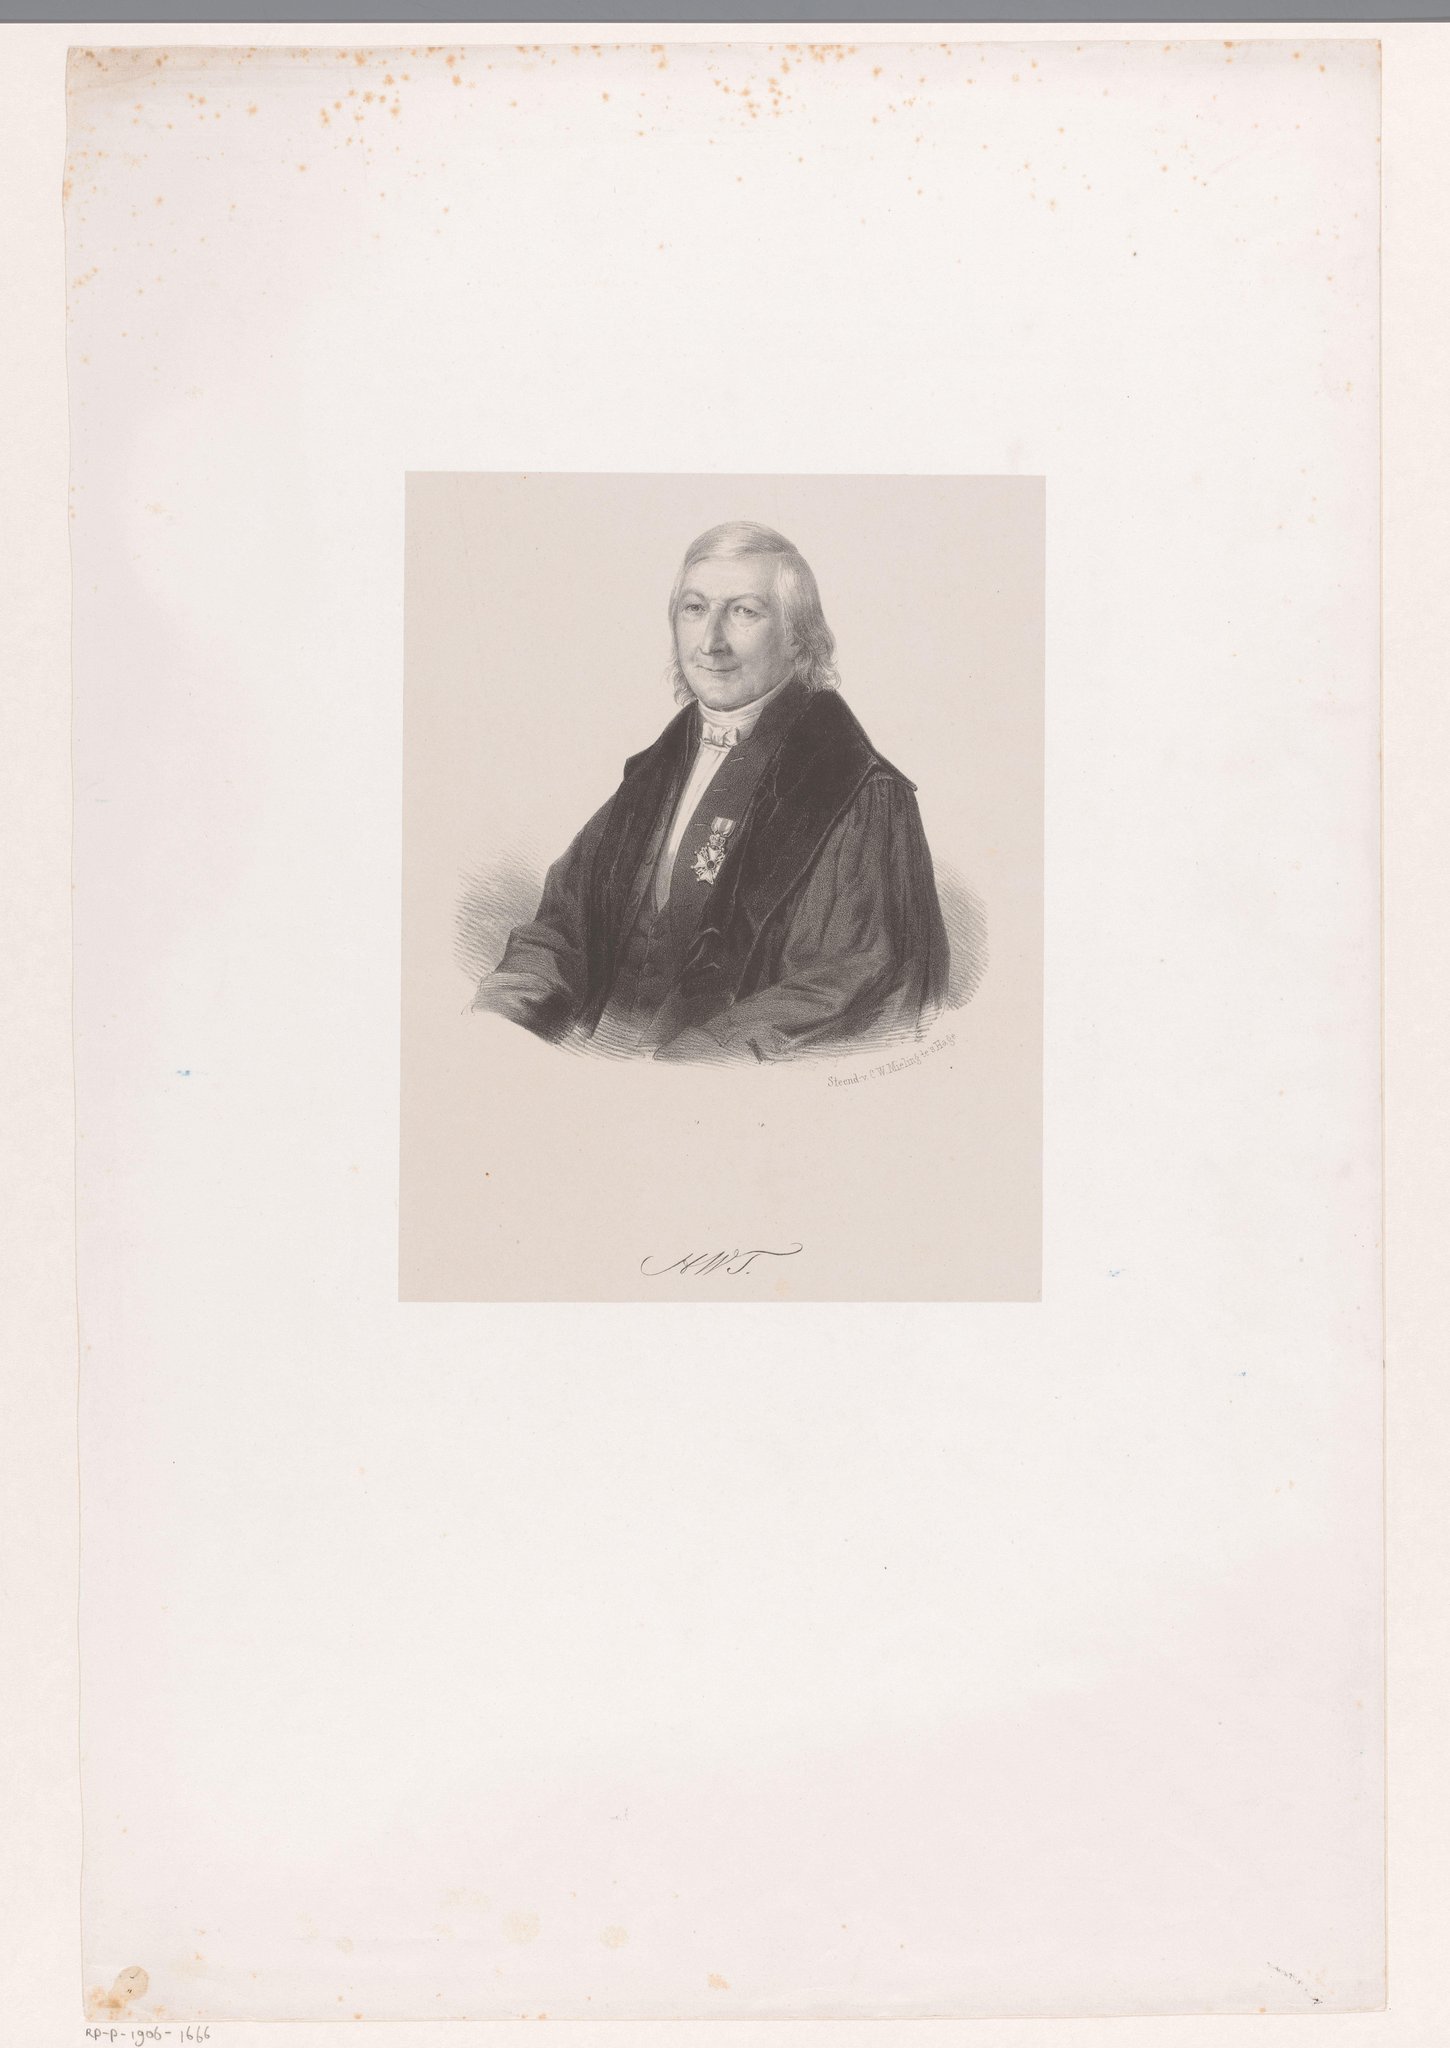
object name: print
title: Portret van Hendrik Willem Tydeman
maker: Anonymous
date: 1845-1847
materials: paper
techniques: lithograph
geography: the hague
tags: utrecht, hendrik willem tydeman, knighthood order, historical persons (+ (full) bust portrait)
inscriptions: collector's mark: Lugt 2228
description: De geportretteerde draagt een toga met ridderorde.